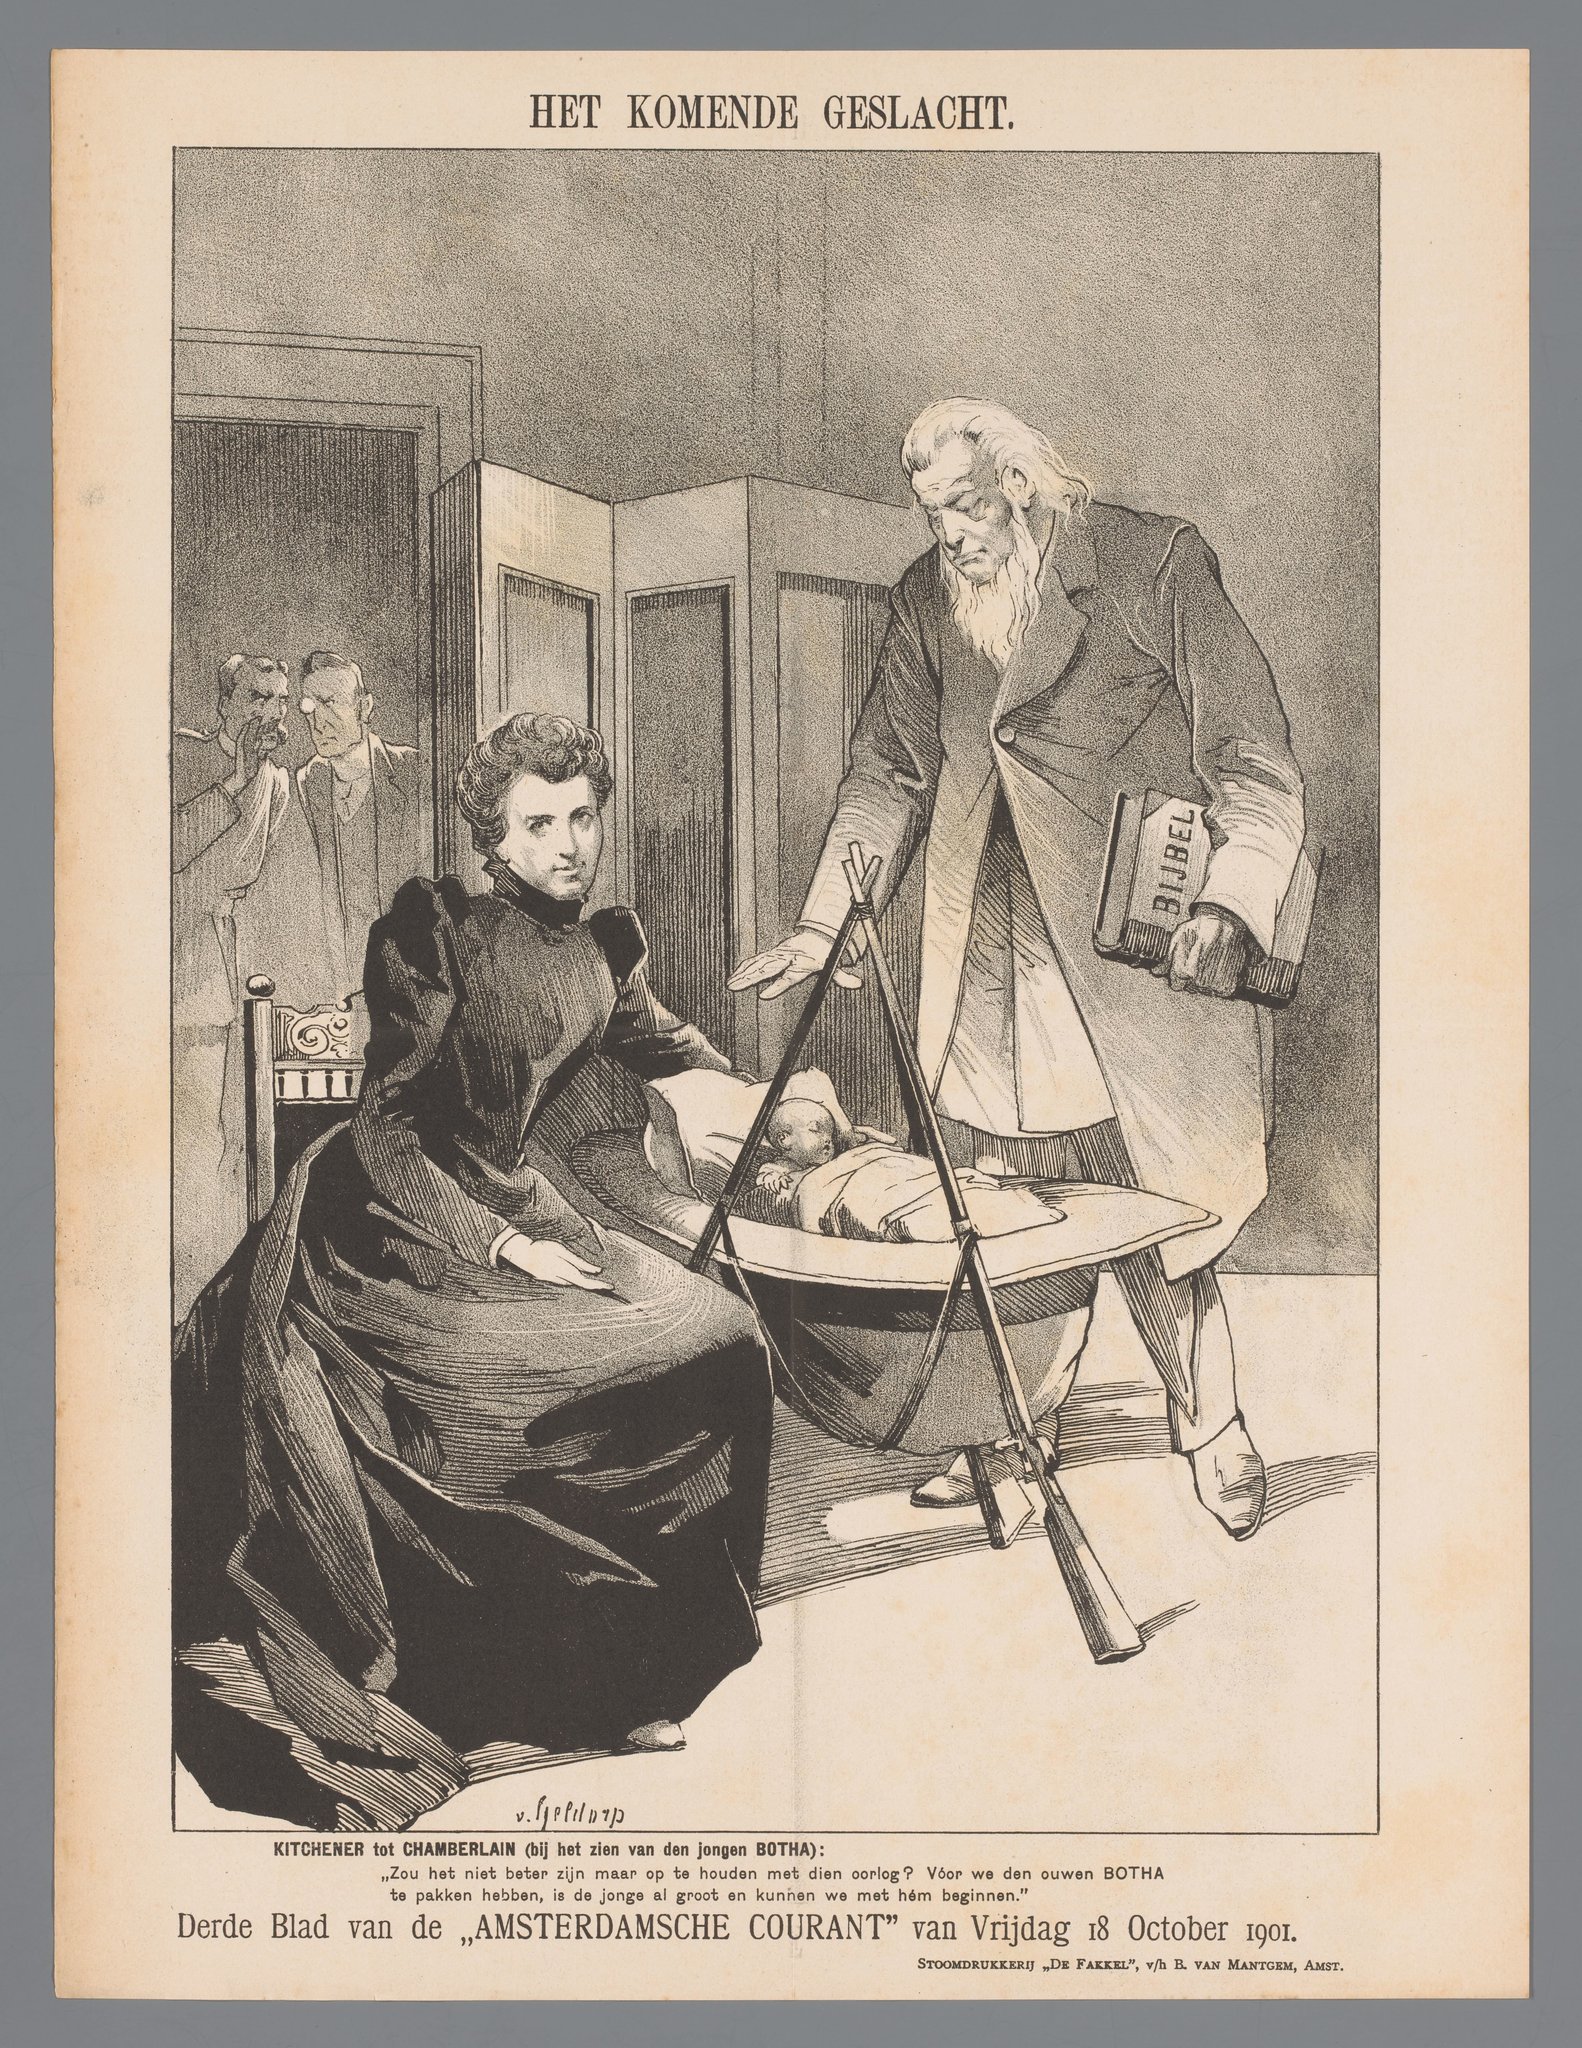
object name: cartoon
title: Het komende geslacht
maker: petrus van geldorp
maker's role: draughtsman, print maker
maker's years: 1872-1939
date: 1901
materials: paper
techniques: lithograph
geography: amsterdam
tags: horatio herbert kitchener, historical persons, politician, e.g. party leader, infant, baby, political caricatures and satires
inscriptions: date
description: Prent uit het bijvoegsel van: De Amsterdamsche Courant, 18 oktober 1901.